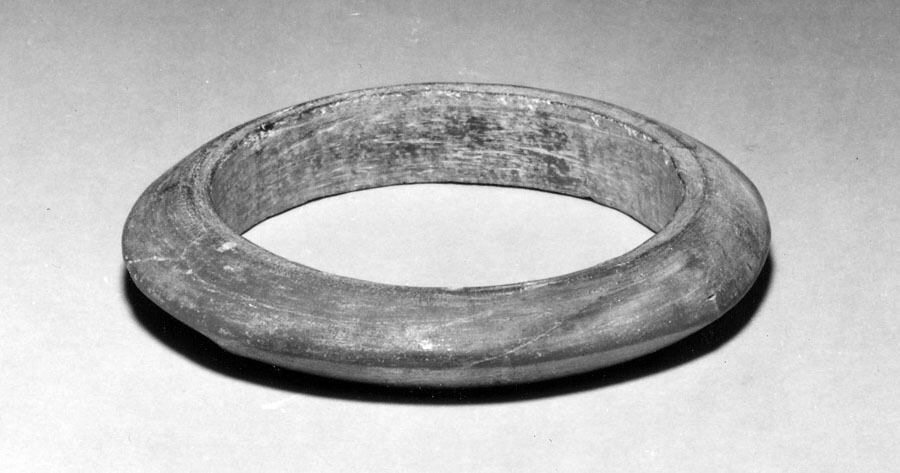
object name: bracelet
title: Aqua-Colored Glass Bracelet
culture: chinese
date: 471-231 BCE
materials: glass